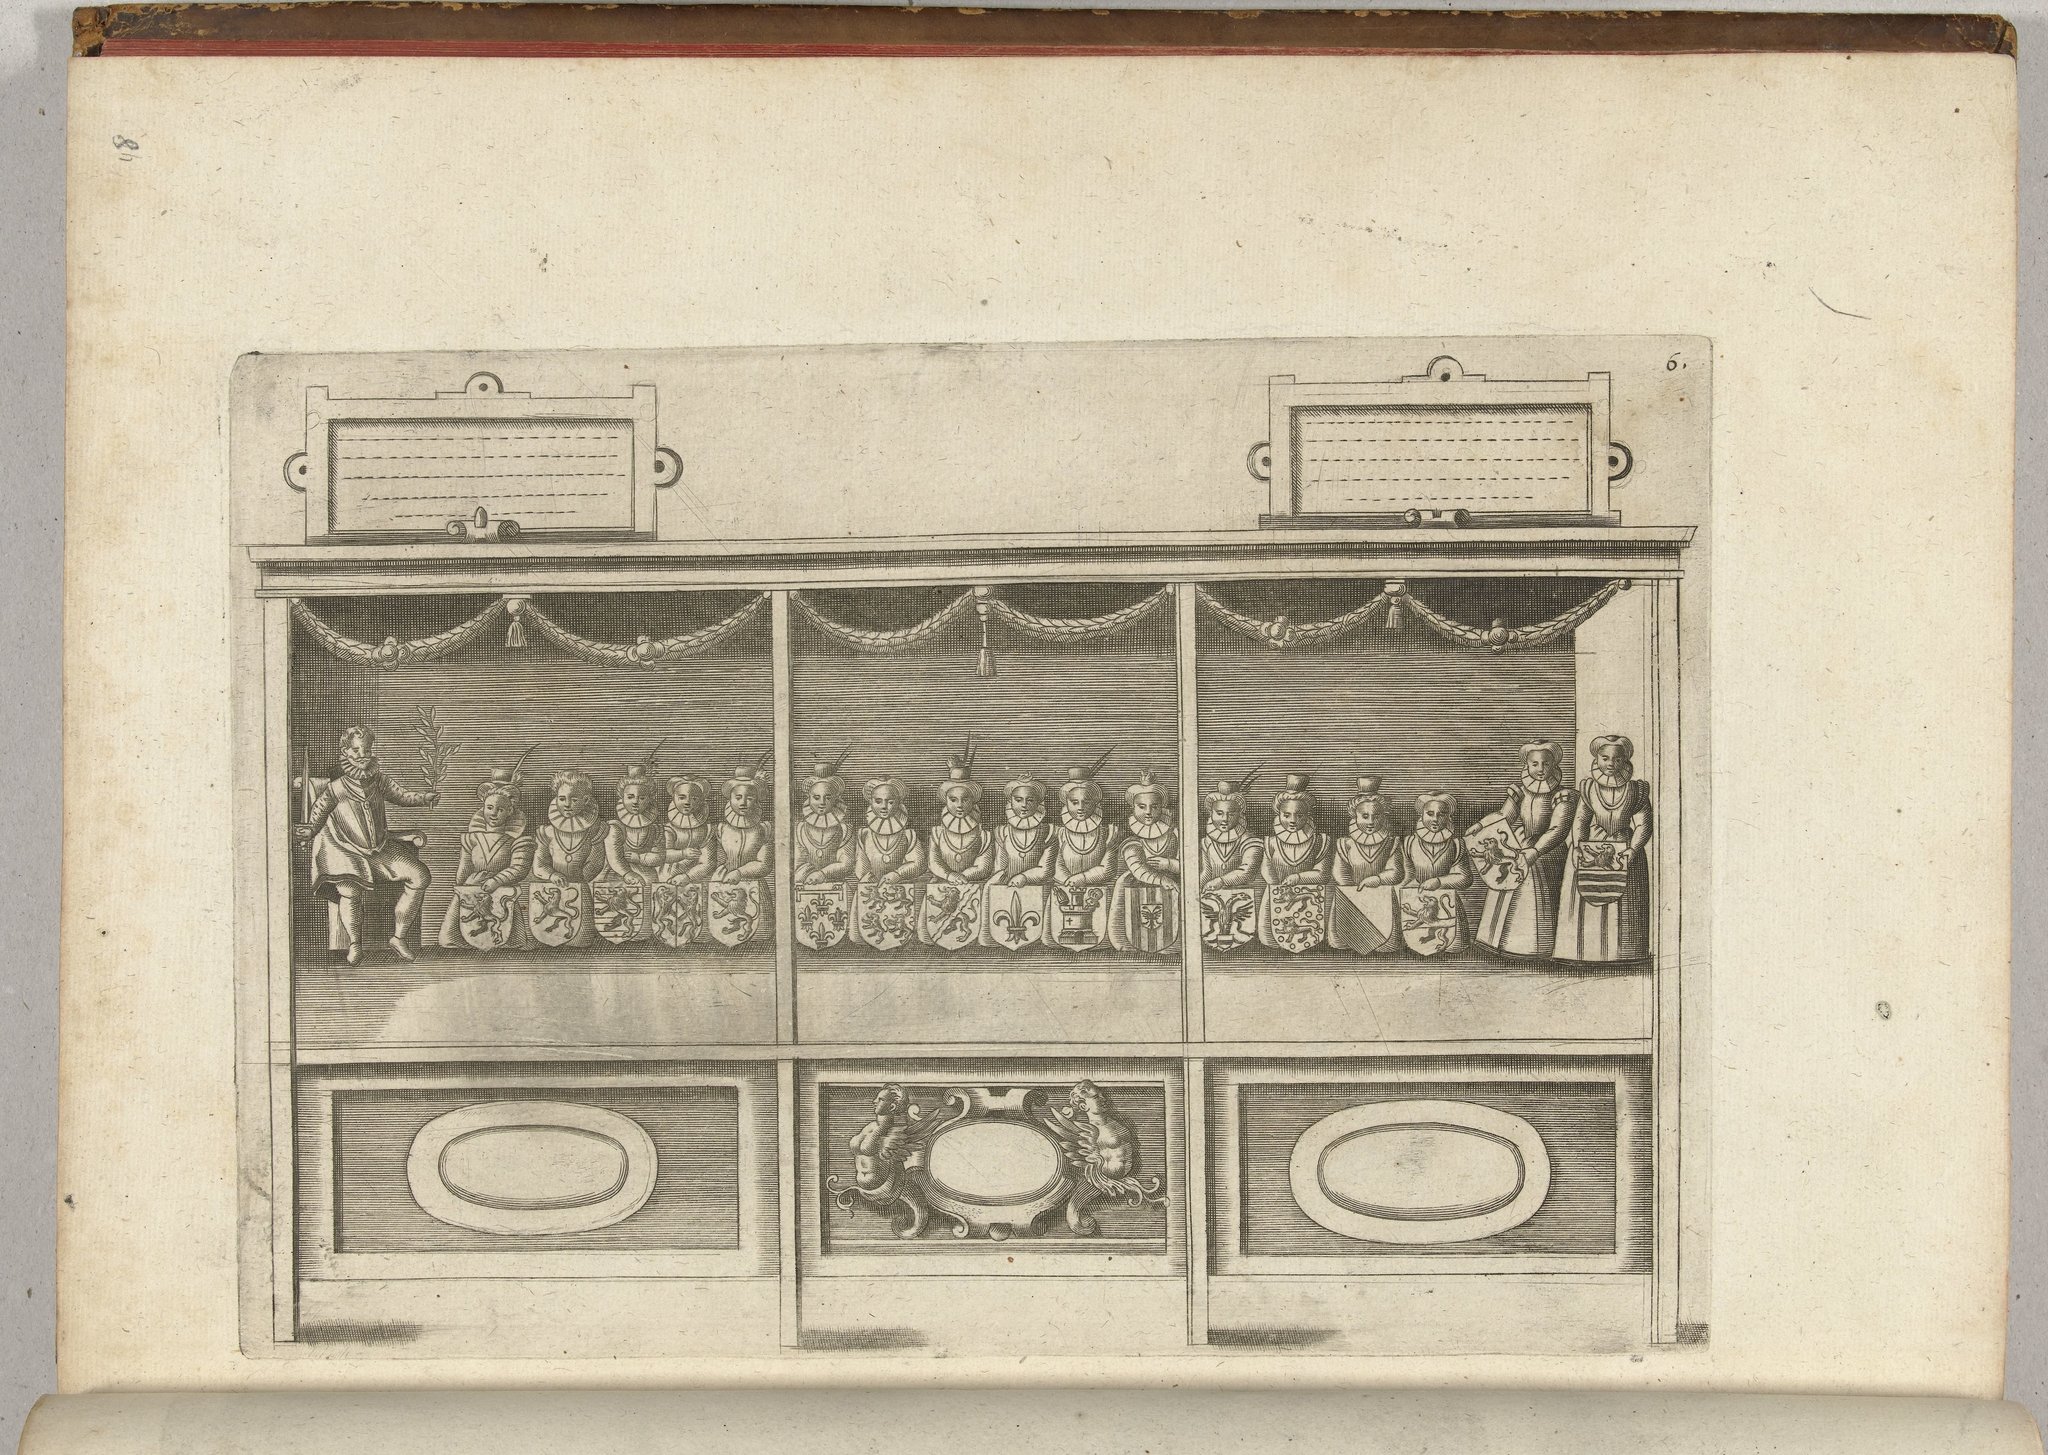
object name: print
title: Toneel met de 17 provincies, 1594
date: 1594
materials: paper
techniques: engraving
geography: southern netherlands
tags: vienna, triumphal entry and public reception, pageant, 'entrée solennelle', 'joyeuse entrée', brussels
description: Toneel met de 17 provincies, 1594. Vijftien zittende provinciemaagden met hun wapens, uiterst rechts alleen de provincies Holland en Zeeland staande. Feestelijke intocht van aartshertog Ernst als gouverneur der Nederlanden gehouden te Brussel op 30 januari 1594. Onderdeel van de beschrijving van deze intocht Descriptio et explicatio pegmatum, arcuum spectaculorum quae Bruxellae Brabant. pridie Cal. Febr. Ao. 1594 exhibita fuere, sub ingressum ... Ernesti ... Archiducis Austriae ... pro Philippo II. Belgicae ditionis gubernatore, J. Mommaert, Brussel 1594. Genummerd: 6.